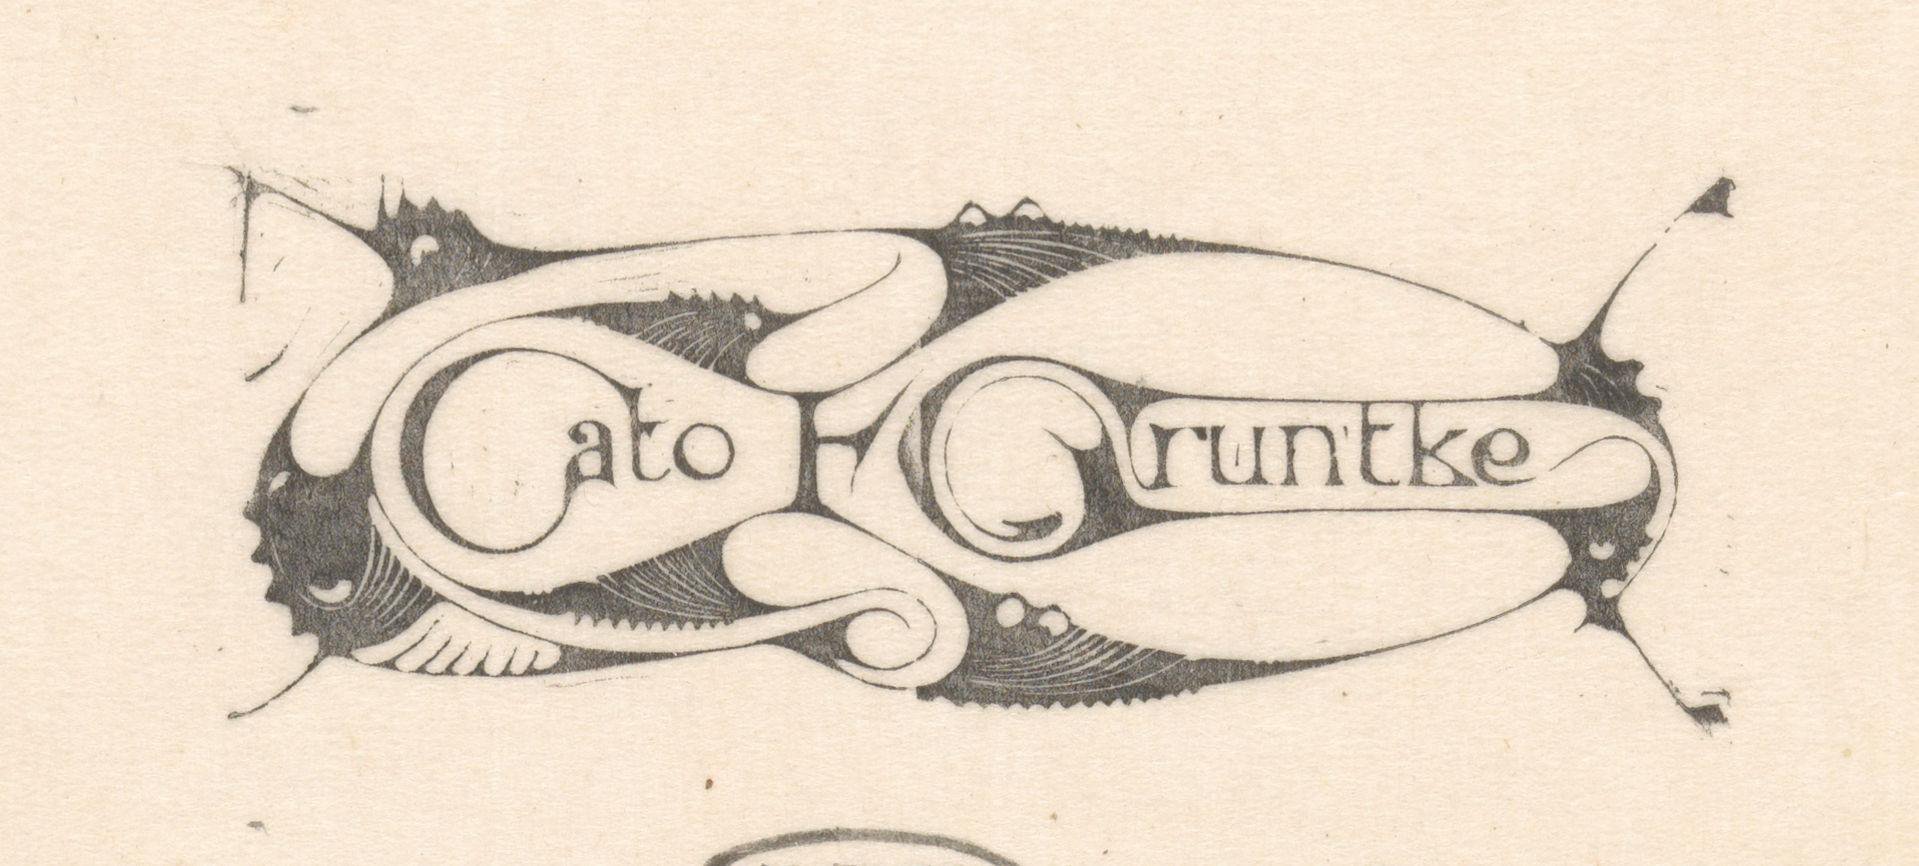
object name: print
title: Visitekaartje van Cato E. Gruntke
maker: karel petrus cornelis de bazel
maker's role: draughtsman, print maker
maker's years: 1869-1923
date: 1896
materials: paper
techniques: woodcut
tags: painter, visiting-card, calling-card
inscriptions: collector's mark: Lugt 2228